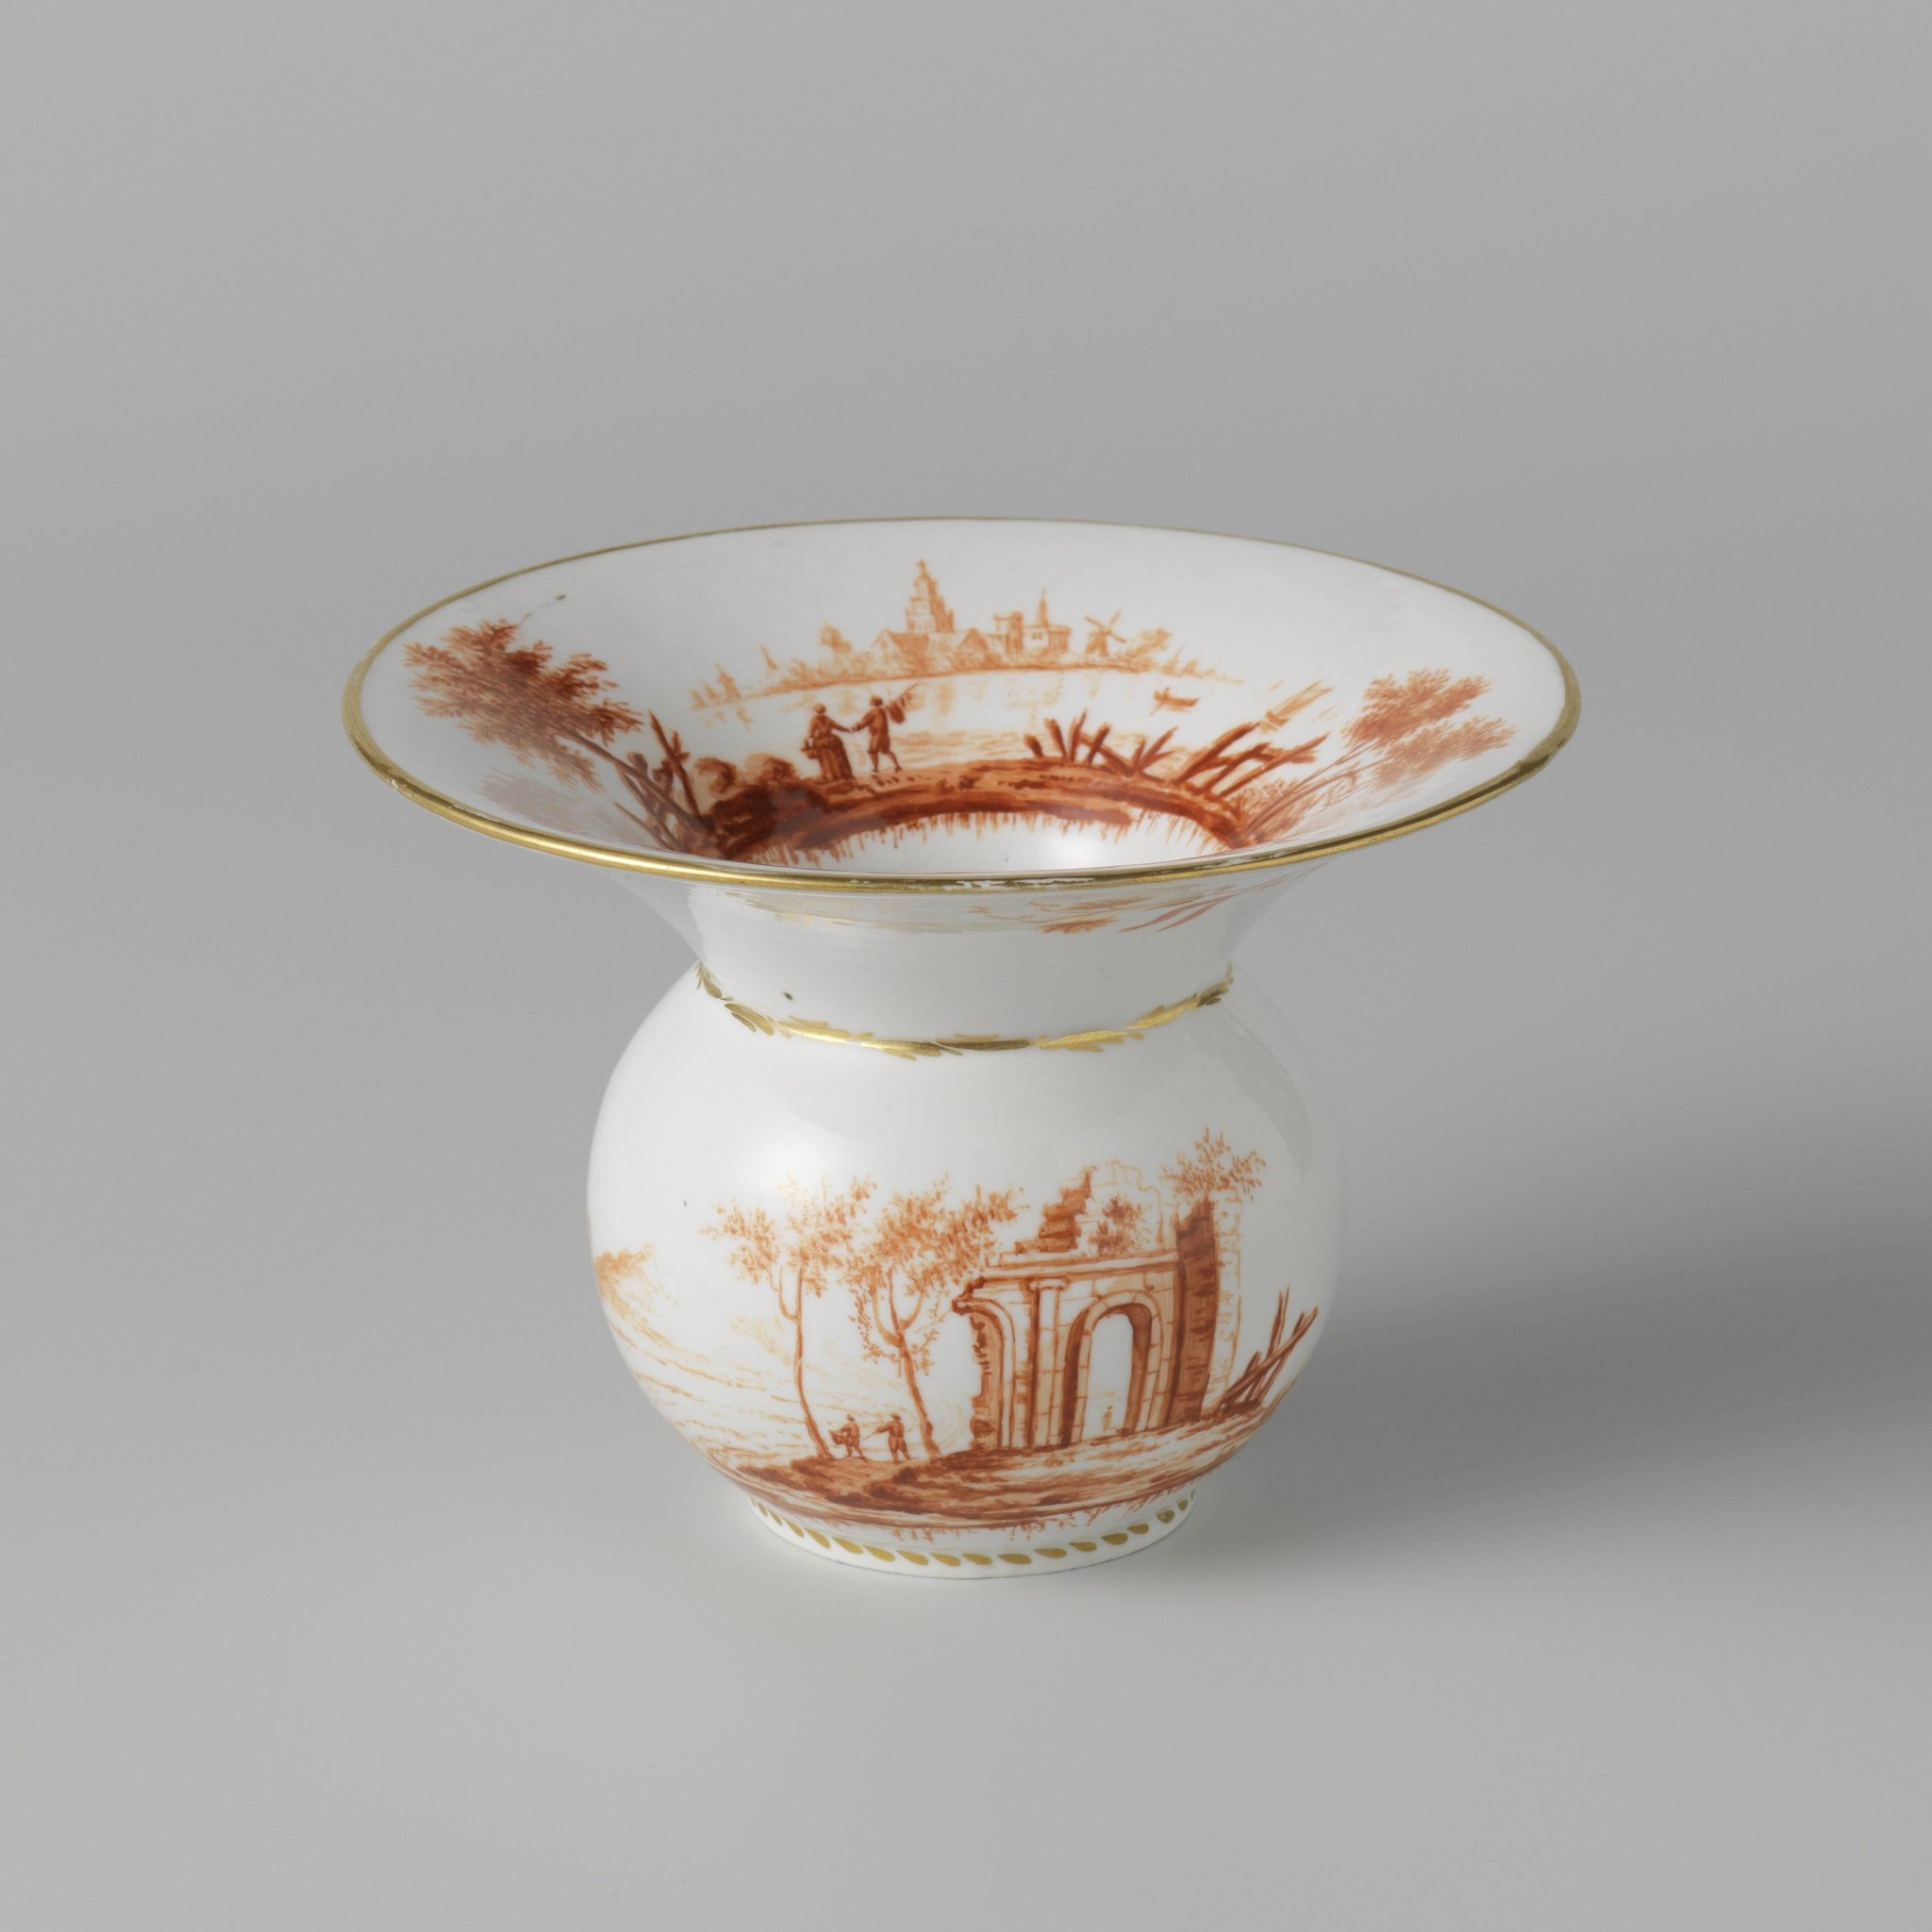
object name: spittoon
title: Kwispedoor, beschilderd met een rivierlandschap met ruïne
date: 1774-1778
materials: porcelain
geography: loosdrecht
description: Cuspidor. Porcelain. Loosdrecht, c. 1774 - 1778. Factory of Joannes de Mol.